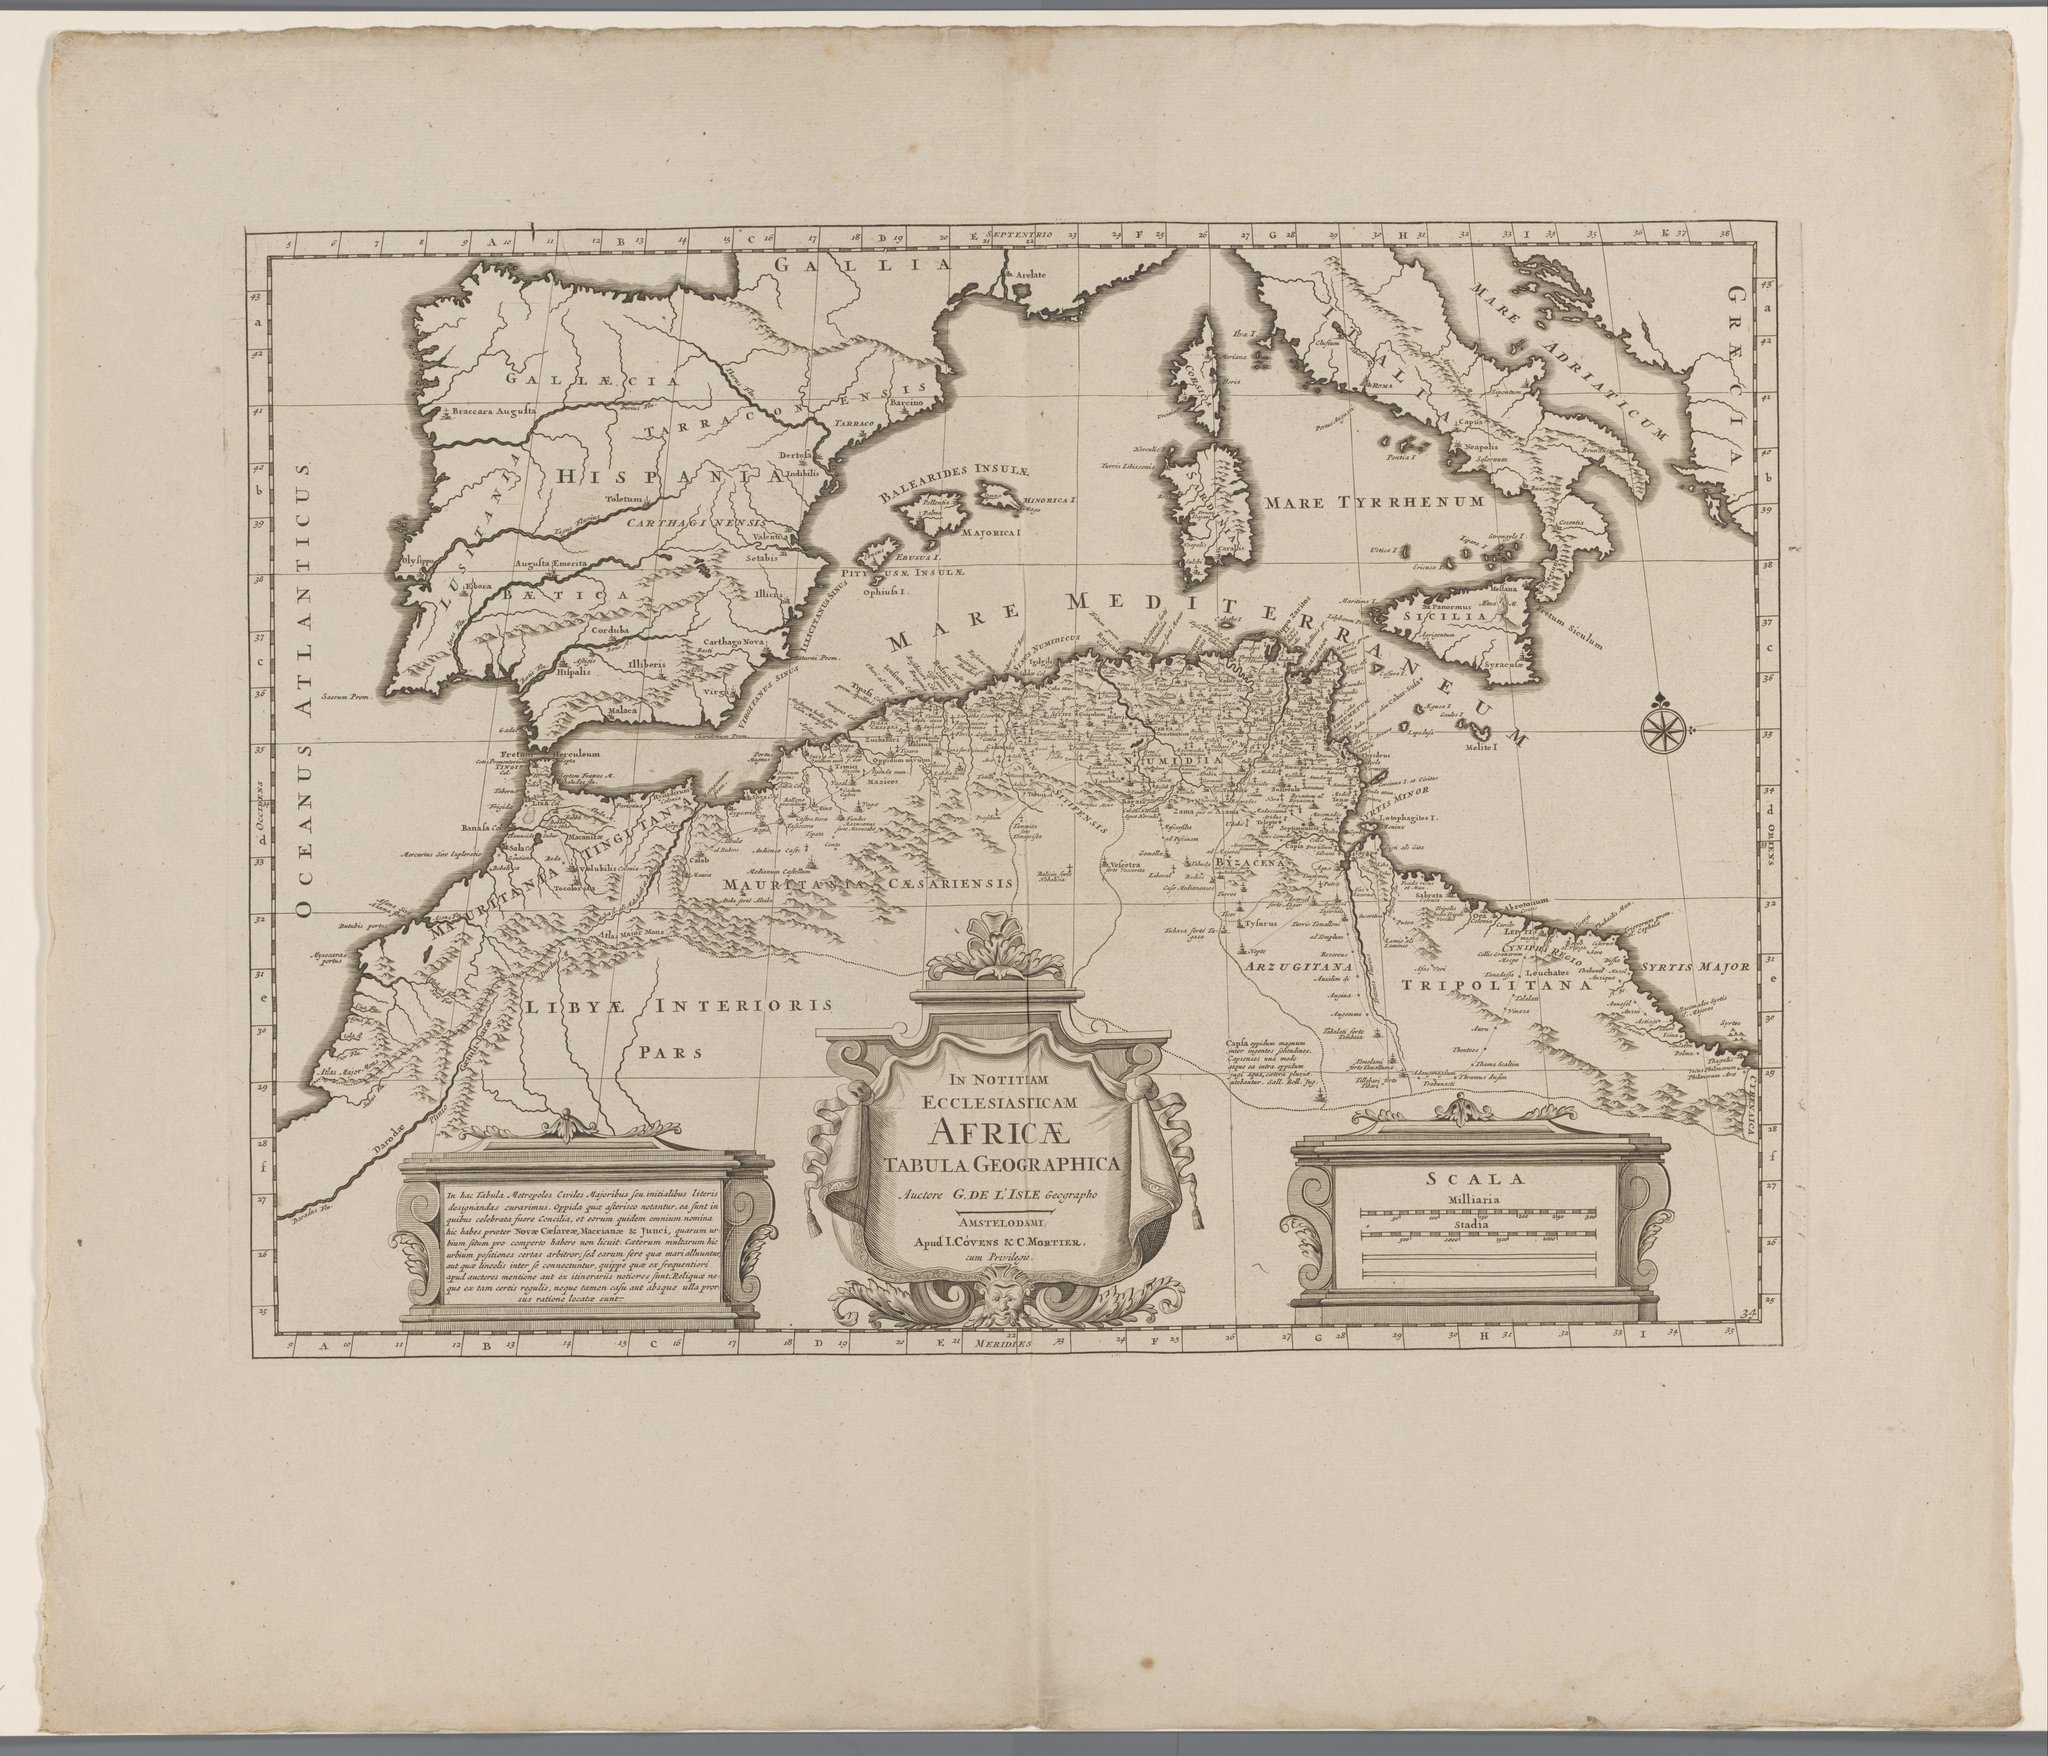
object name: print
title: In notitiam ecclesiasticam Africae tabula geographica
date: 1730-1774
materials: paper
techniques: engraving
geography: paris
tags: maps of separate countries or regions, italy, spain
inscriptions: collector's mark: Lugt 2228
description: Op de kaart zijn de handelsroutes in Noord-Afrika nauwkeurig weergegeven. Rechtsonder genummerd: 34.